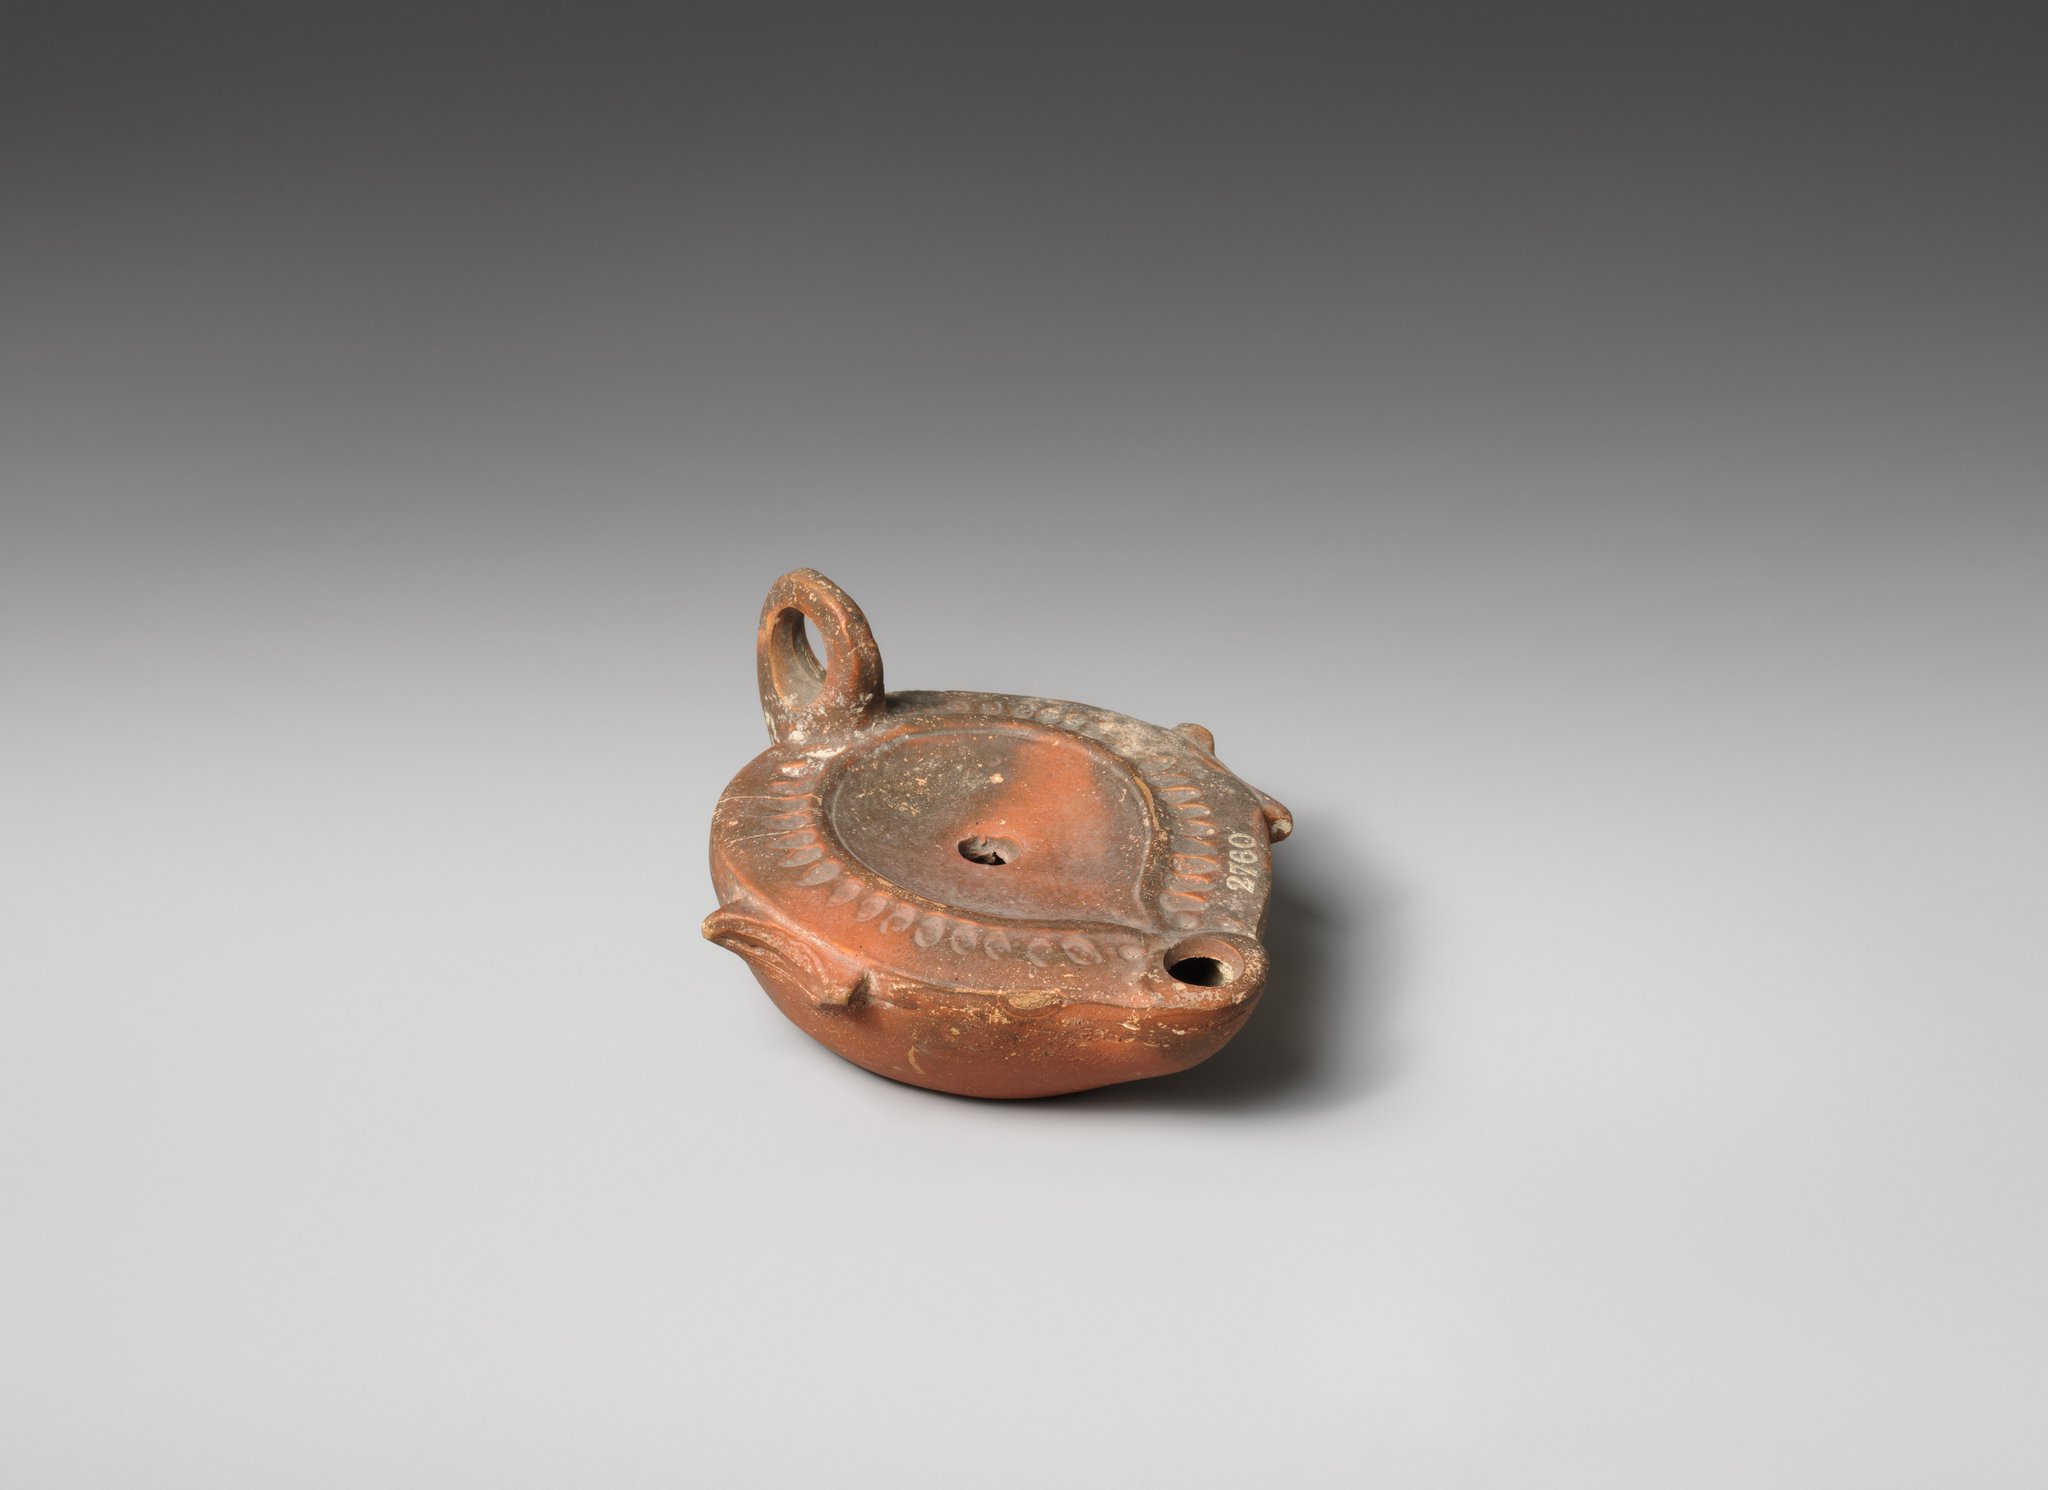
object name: lamp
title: Terracotta oil lamp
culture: roman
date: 101-200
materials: terracotta